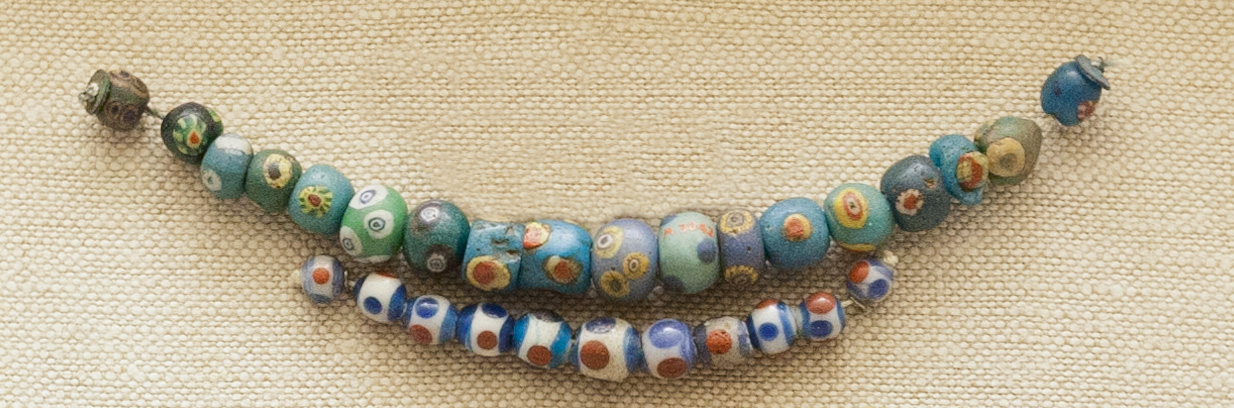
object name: necklace, bead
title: String of 18 Eyed Beads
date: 1-1000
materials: glass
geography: egypt